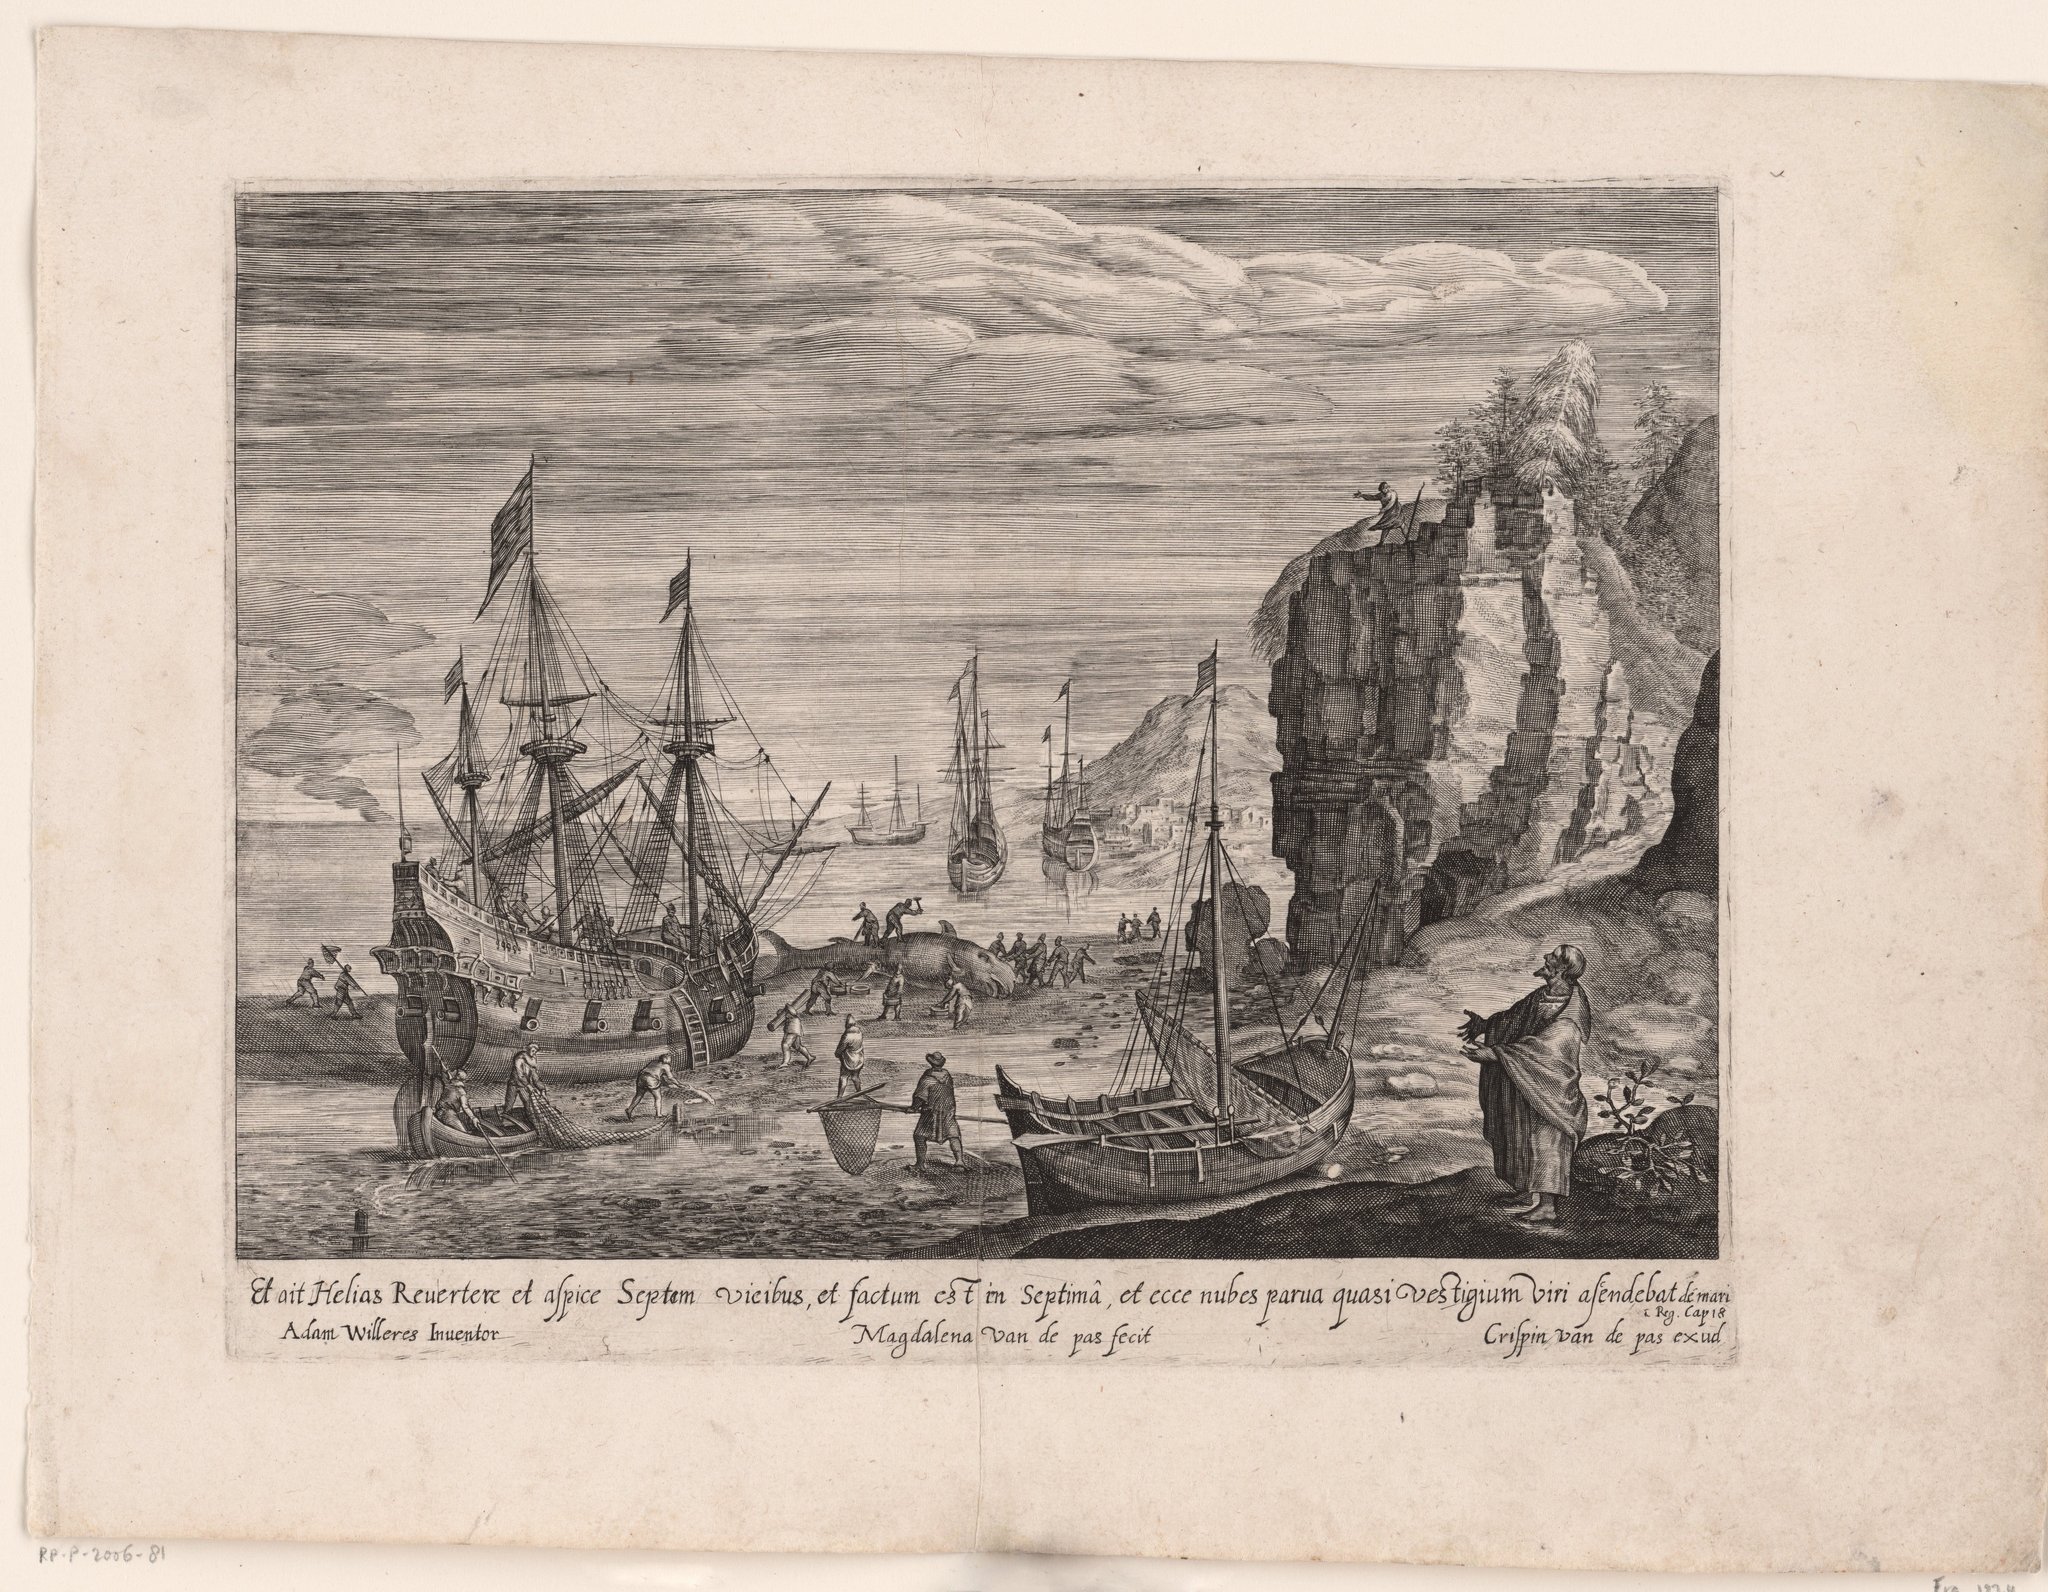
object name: print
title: Landscapes with the Story of Elijah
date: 1617-1634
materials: paper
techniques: engraving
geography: utrecht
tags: the servant reports he has seen a small cloud ~ story of elijah, swimming mammals: whale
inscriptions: collector's mark: Lugt 2760, collector's mark: Lugt 2228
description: Magdalena de Passe based these impressive landscapes on paintings by the landscape painters Adam Willaerts and Roelant Savery. On her own initiative, the printmaker turned them into a narrative series by incorporating in them scenes from the life of the prophet Elijah. De Passe’s subtle engraving technique comes into its own in the rocky outcrops, waters and rolling hills. You can almost distinguish each leaf in the foliage of the trees.